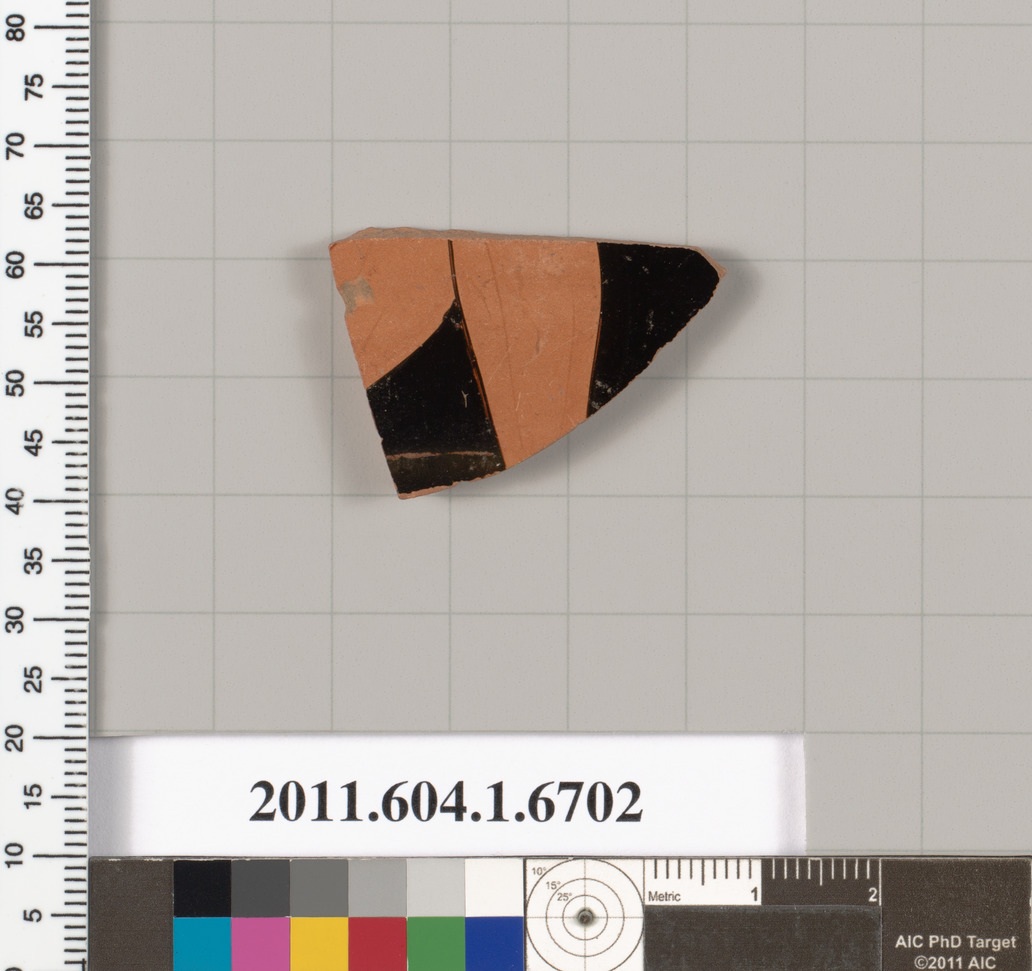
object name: kylix fragment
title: Terracotta fragment of a kylix (drinking cup)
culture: greek, attic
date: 490-470 BCE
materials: terracotta